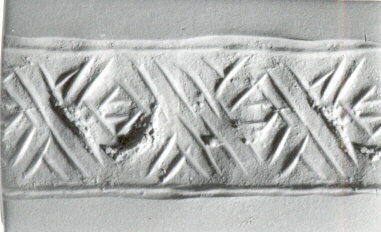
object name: cylinder seal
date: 3200-2900 BCE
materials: marble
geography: mesopotamia